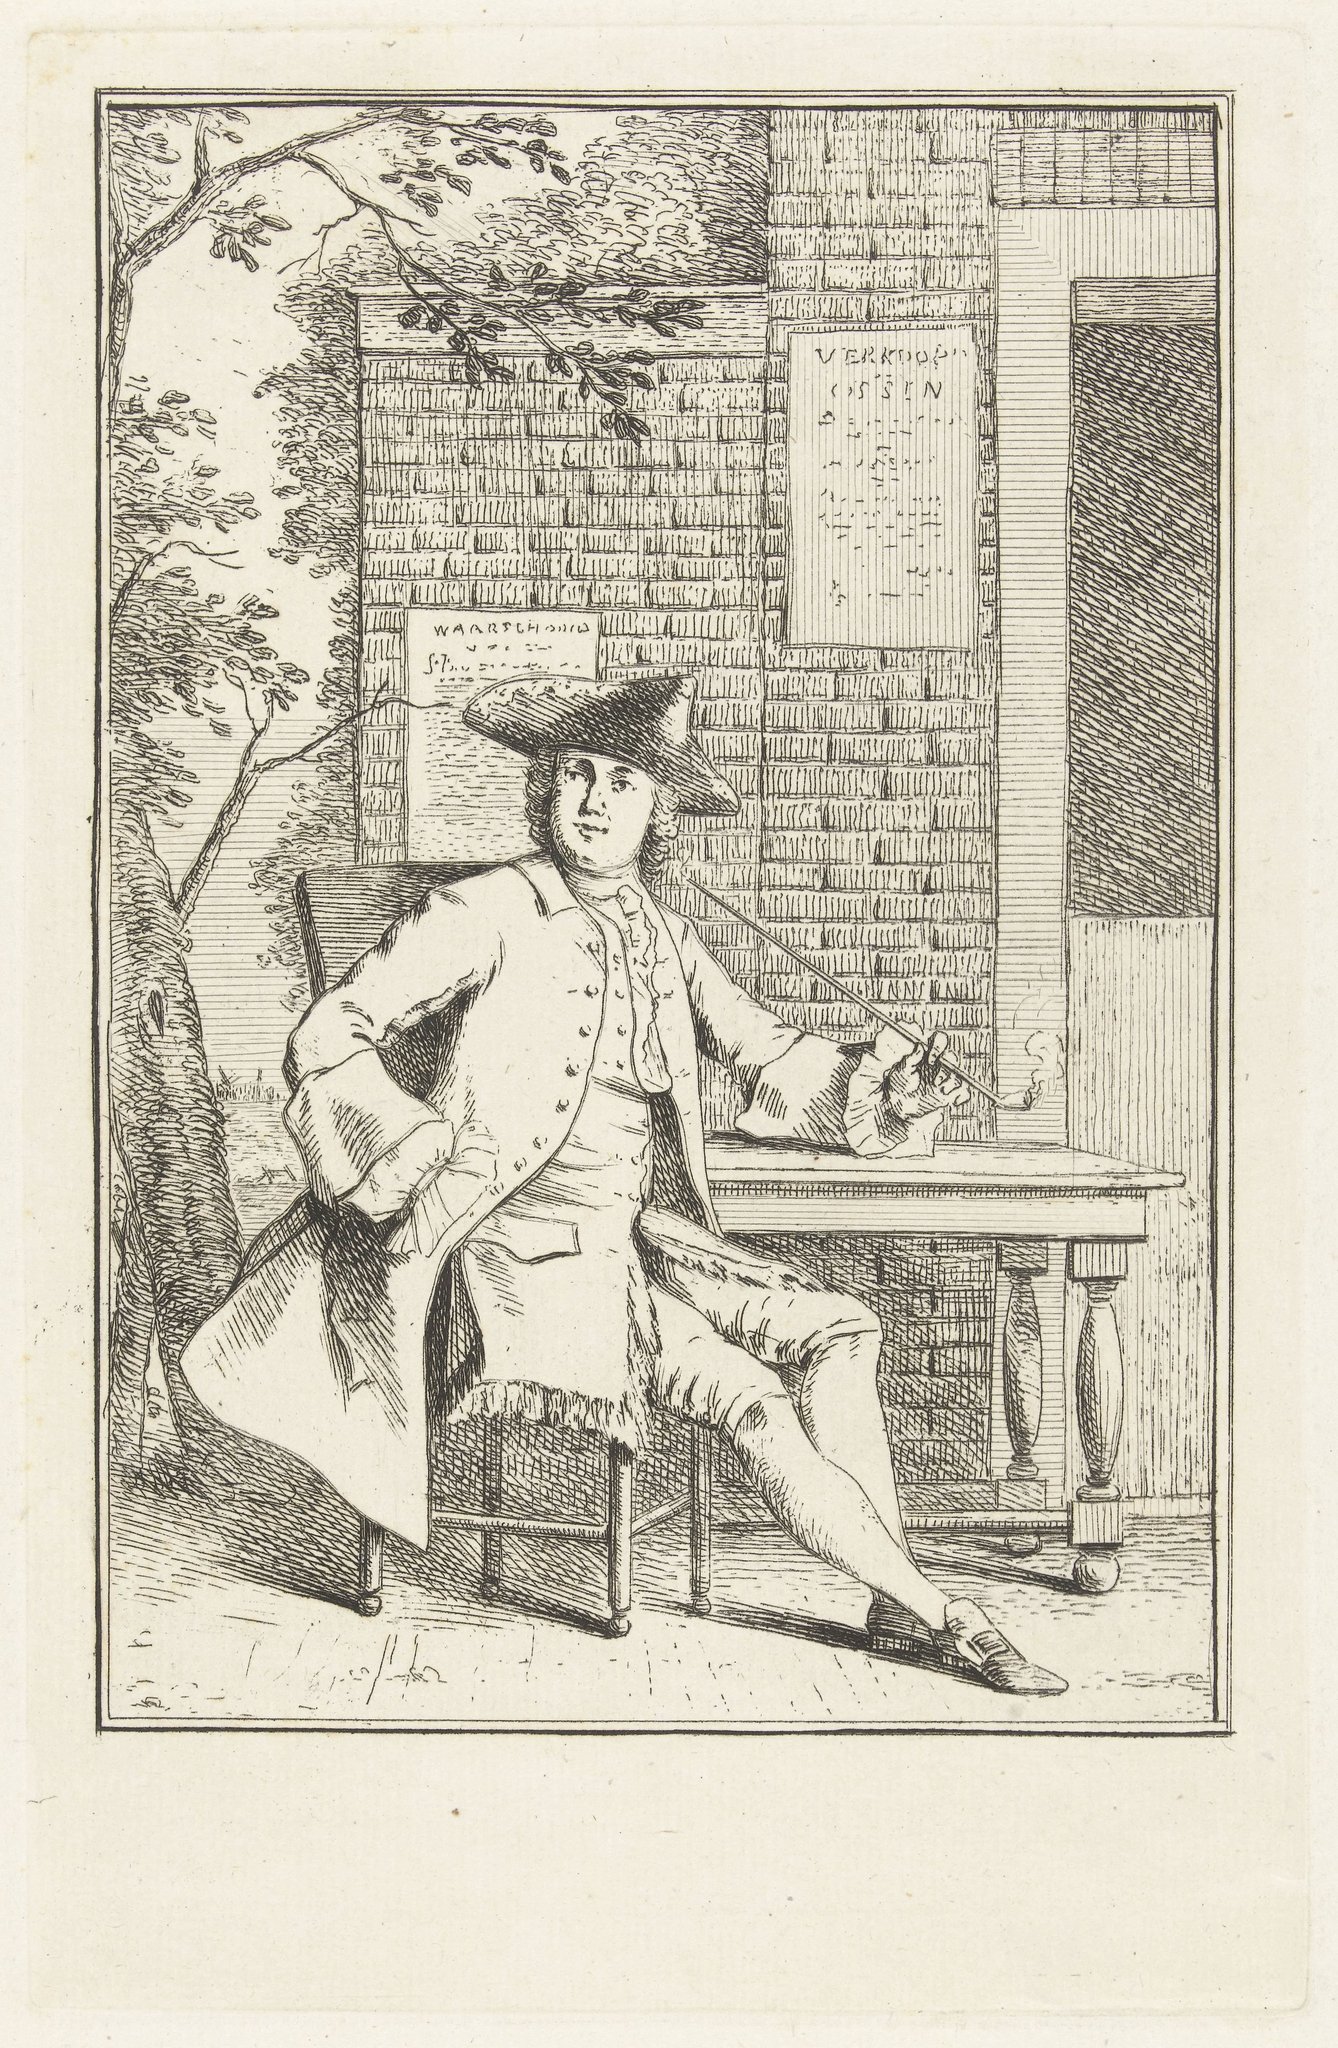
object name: print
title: Zittende rokende man (zelfportret?)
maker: jacobus buys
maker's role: draughtsman, print maker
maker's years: 1724-1801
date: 1740-1801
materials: paper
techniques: etching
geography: amsterdam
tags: amsterdam, print maker, draughtsman, jacobus buys, poster, foodstuffs; still life of foodstuffs (+ taking (particular) foodstuffs: eating, drinking, smoking, chewing, etc.)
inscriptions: collector's mark: Lugt 240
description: Een man zit voor een huis aan een tafel en rookt een pijp met een lange steel. Aan de muur van het huis zitten aanplakbiljetten. De man draagt een driepuntige steek, een lange overjas en een knielange broek. Wellicht zelfportret van de kunstenaar Jacob Buys.